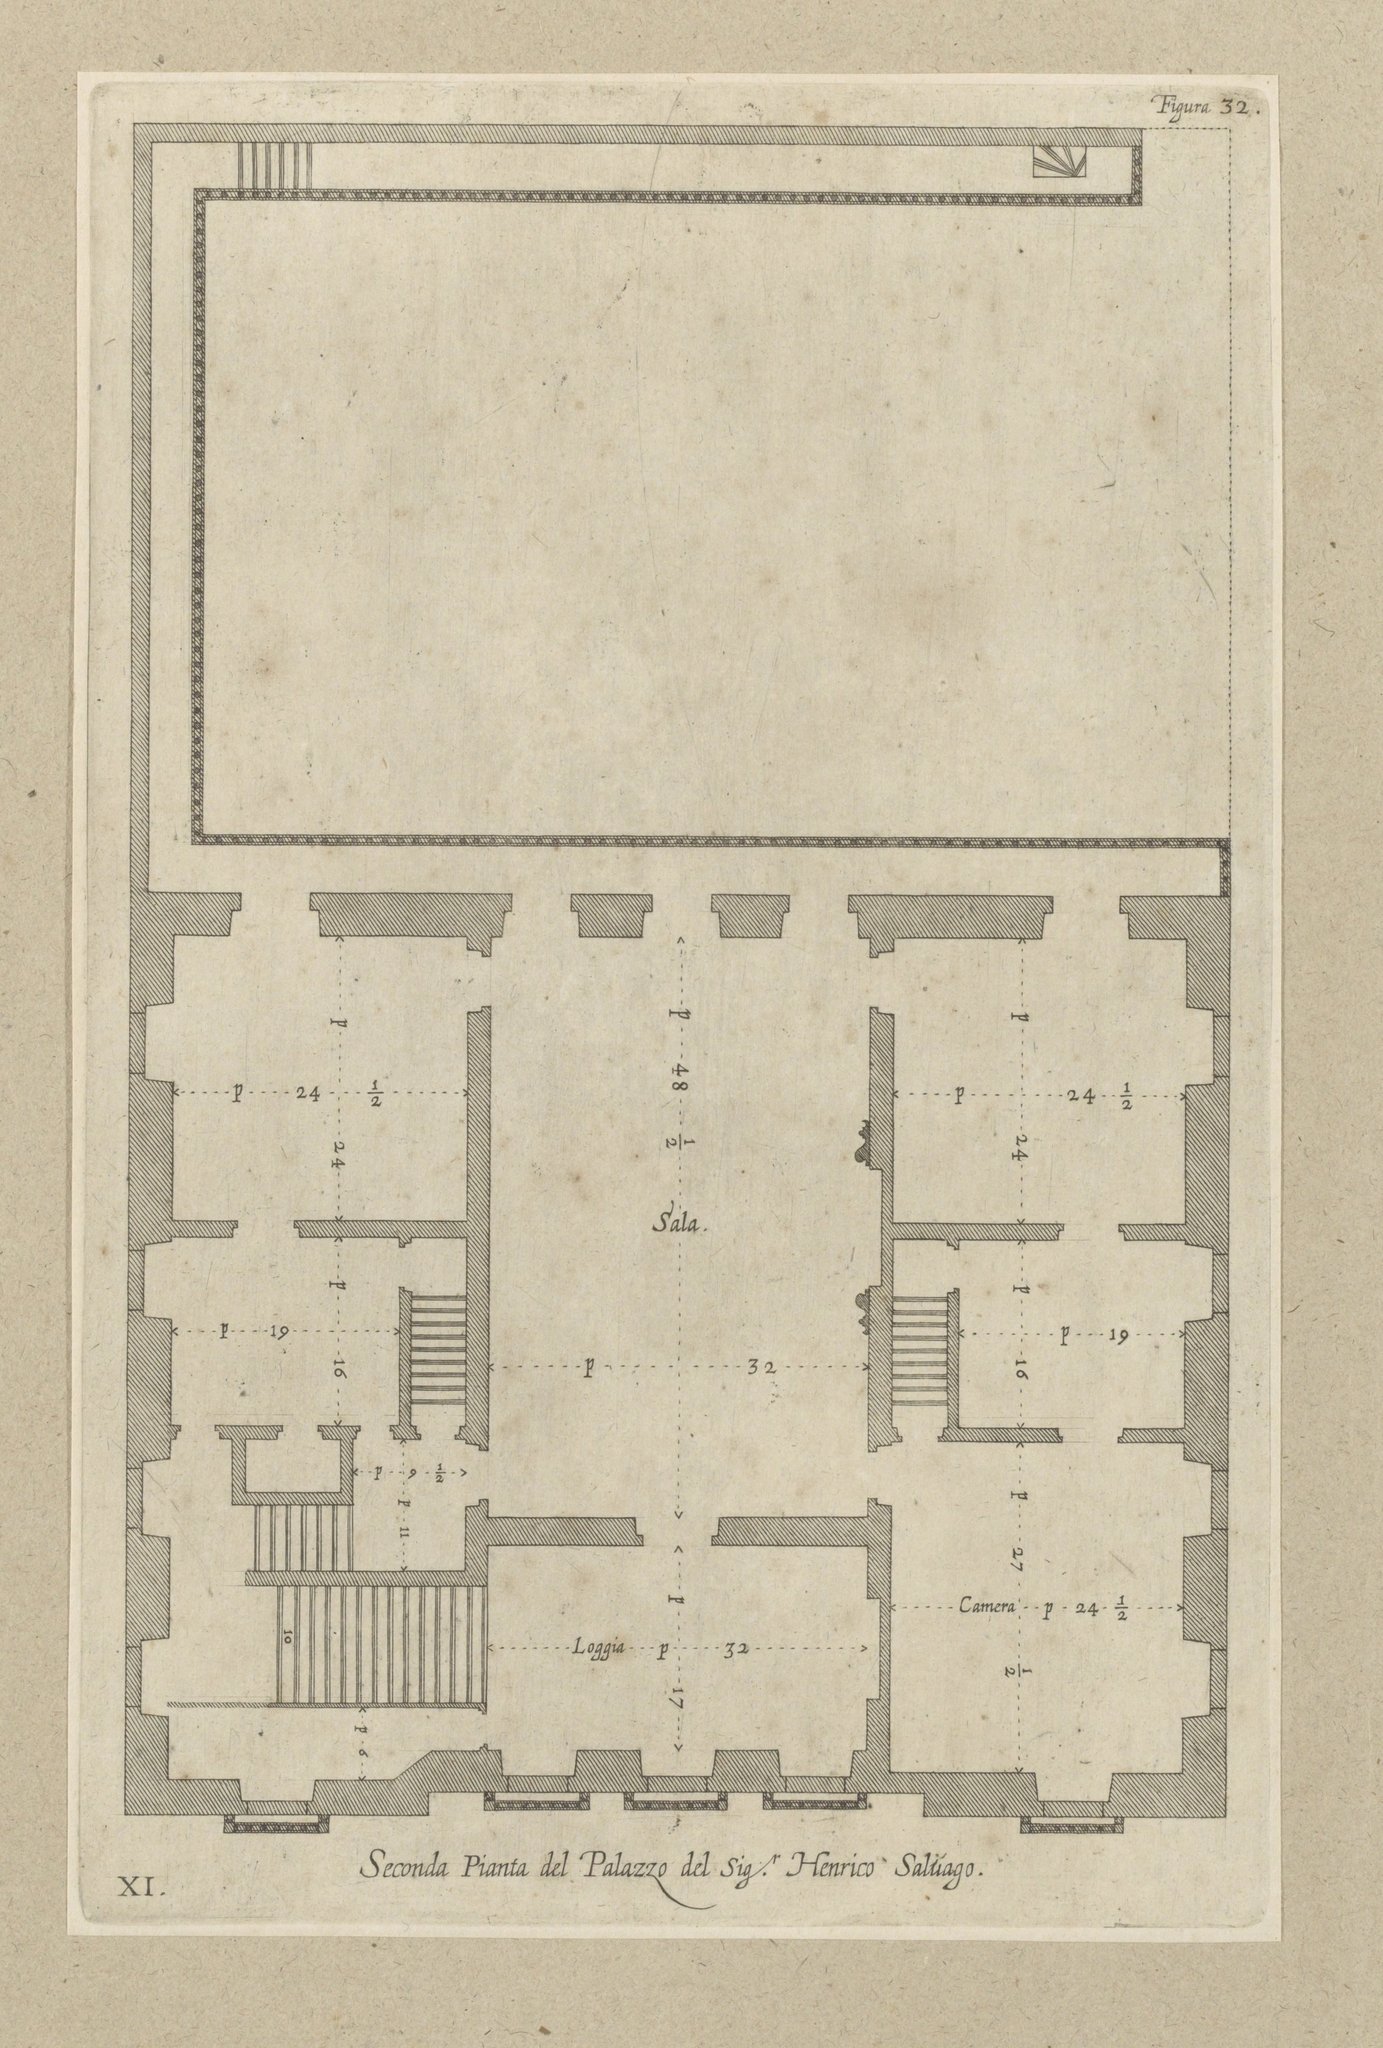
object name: print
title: Prima pianta del Palazzo del sigr. Henrico Salvago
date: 1622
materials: paper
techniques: engraving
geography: antwerp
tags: hôtel, i.e. small palace in city - aa - civic architecture: inside, plan ~ architecture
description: Deze prent maakt deel uit van een album.